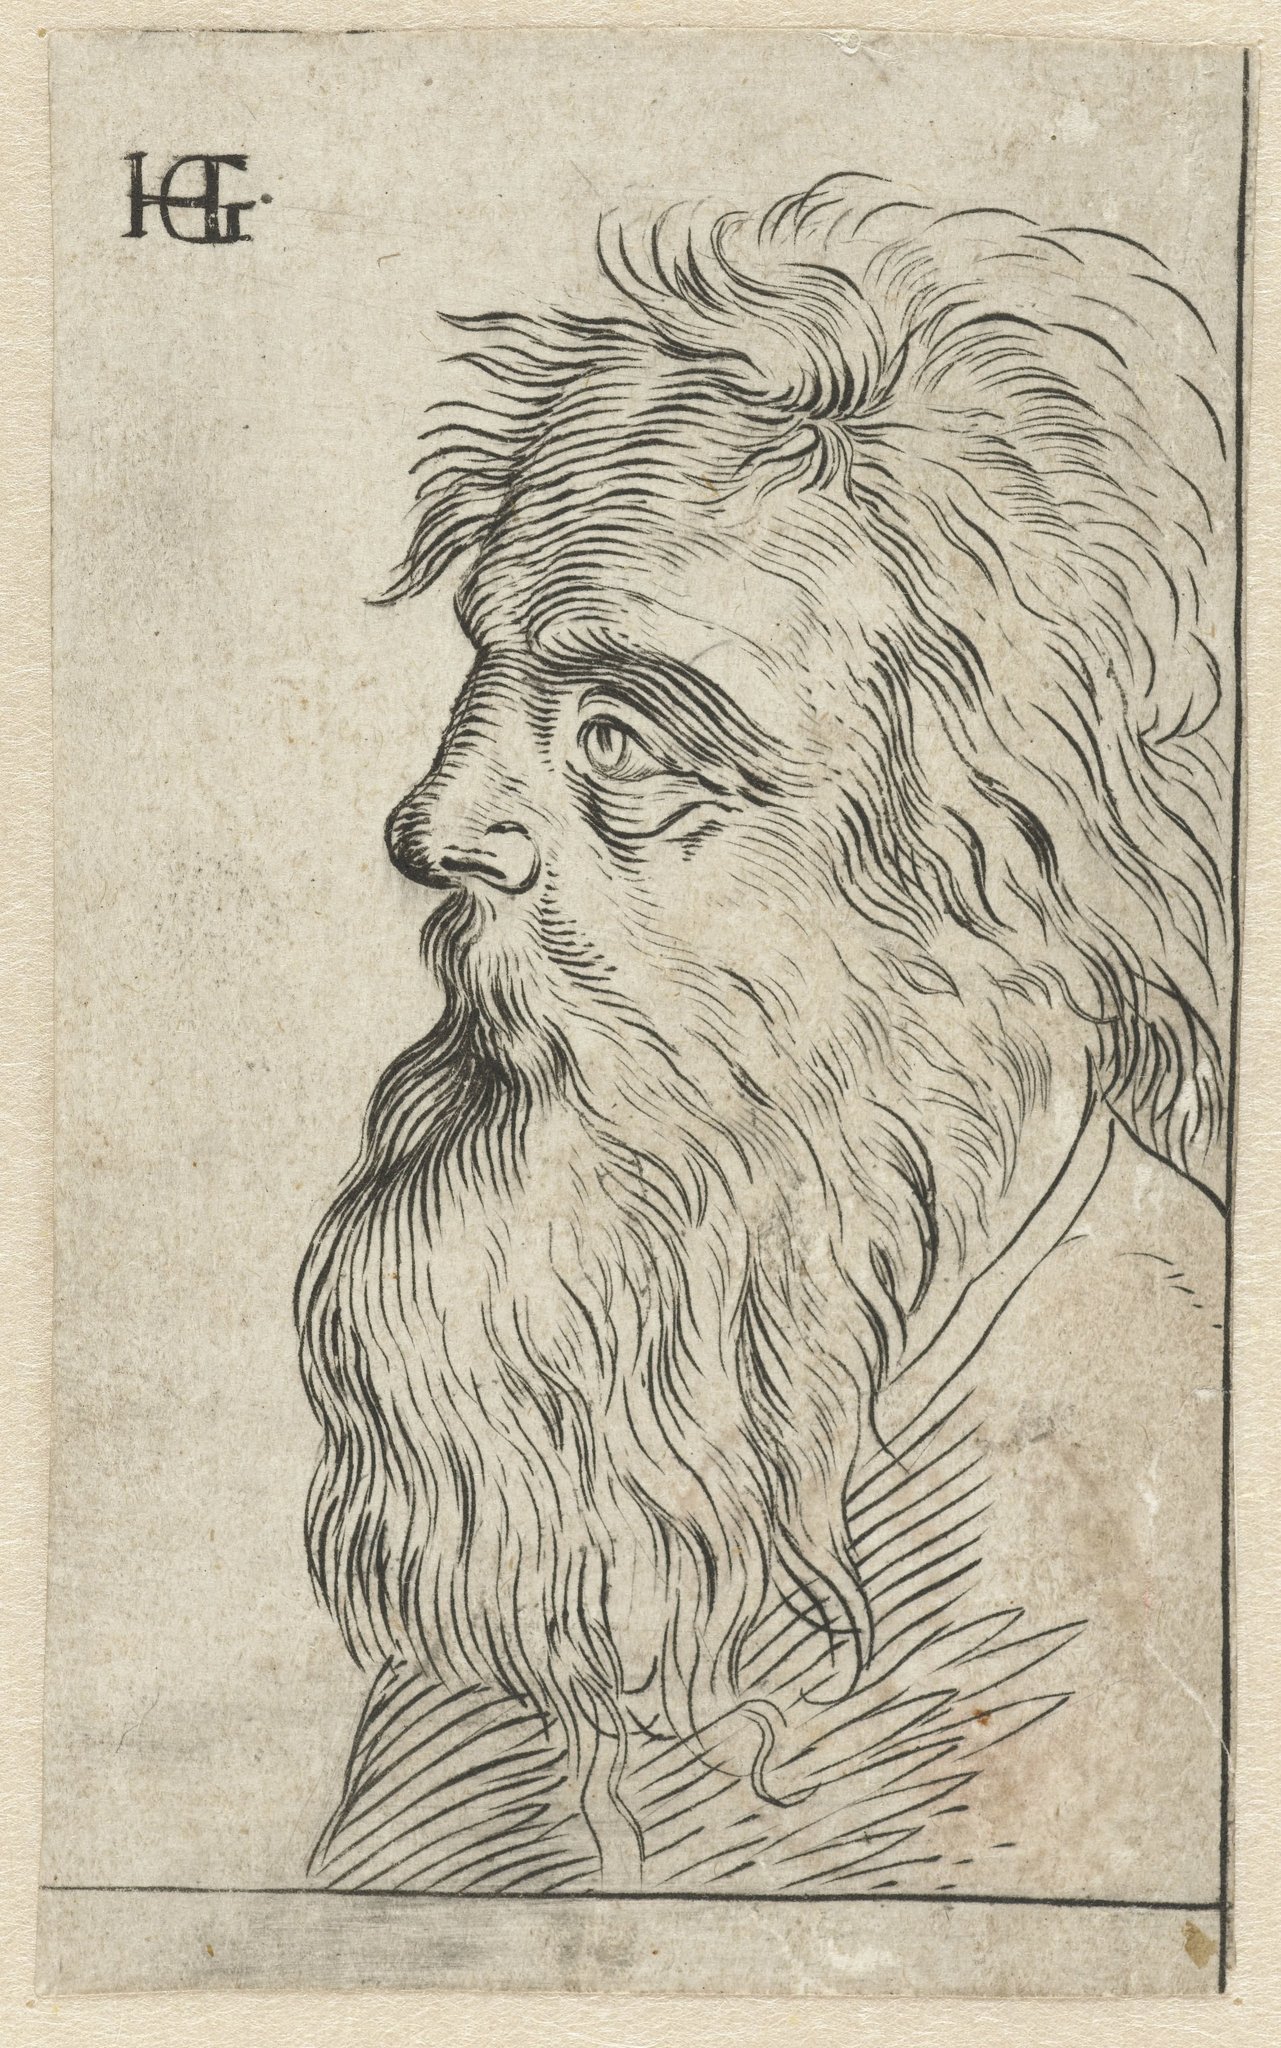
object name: print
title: Profiel van een bebaarde man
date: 1600-1610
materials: paper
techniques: engraving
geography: netherlands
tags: person with big beard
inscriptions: collector's mark: Lugt 240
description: Busteportret van een oudere man met een baard, en profil.